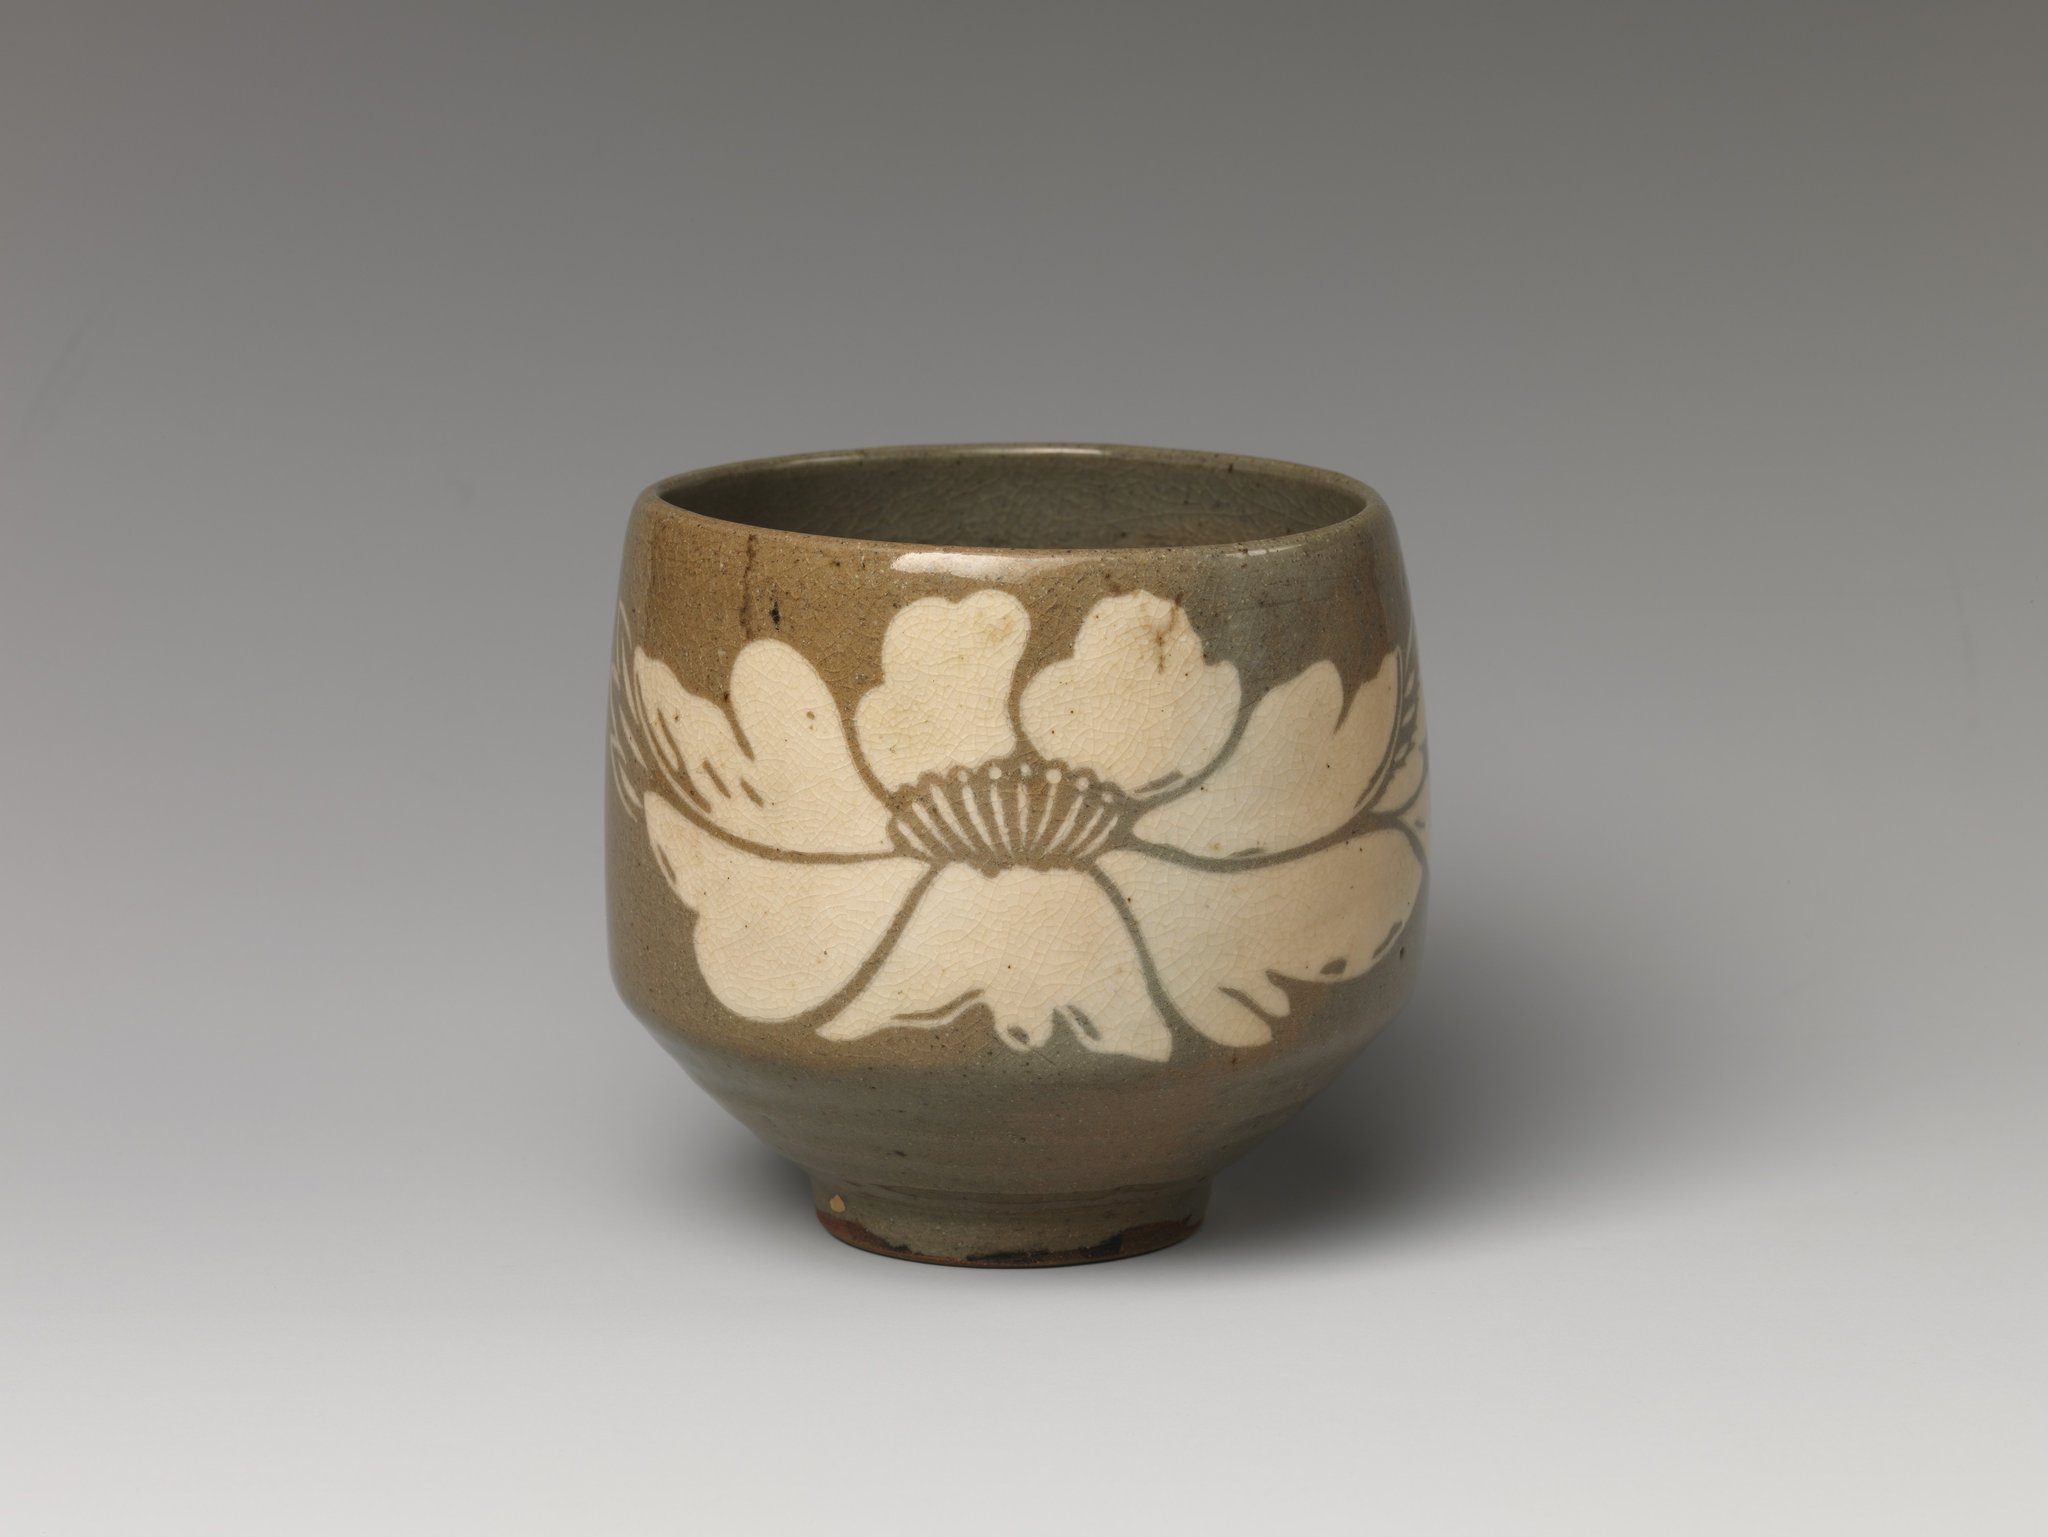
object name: teabowl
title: Tea Bowl with Peony Decoration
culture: japanese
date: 1801-1900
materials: stoneware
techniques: inlay